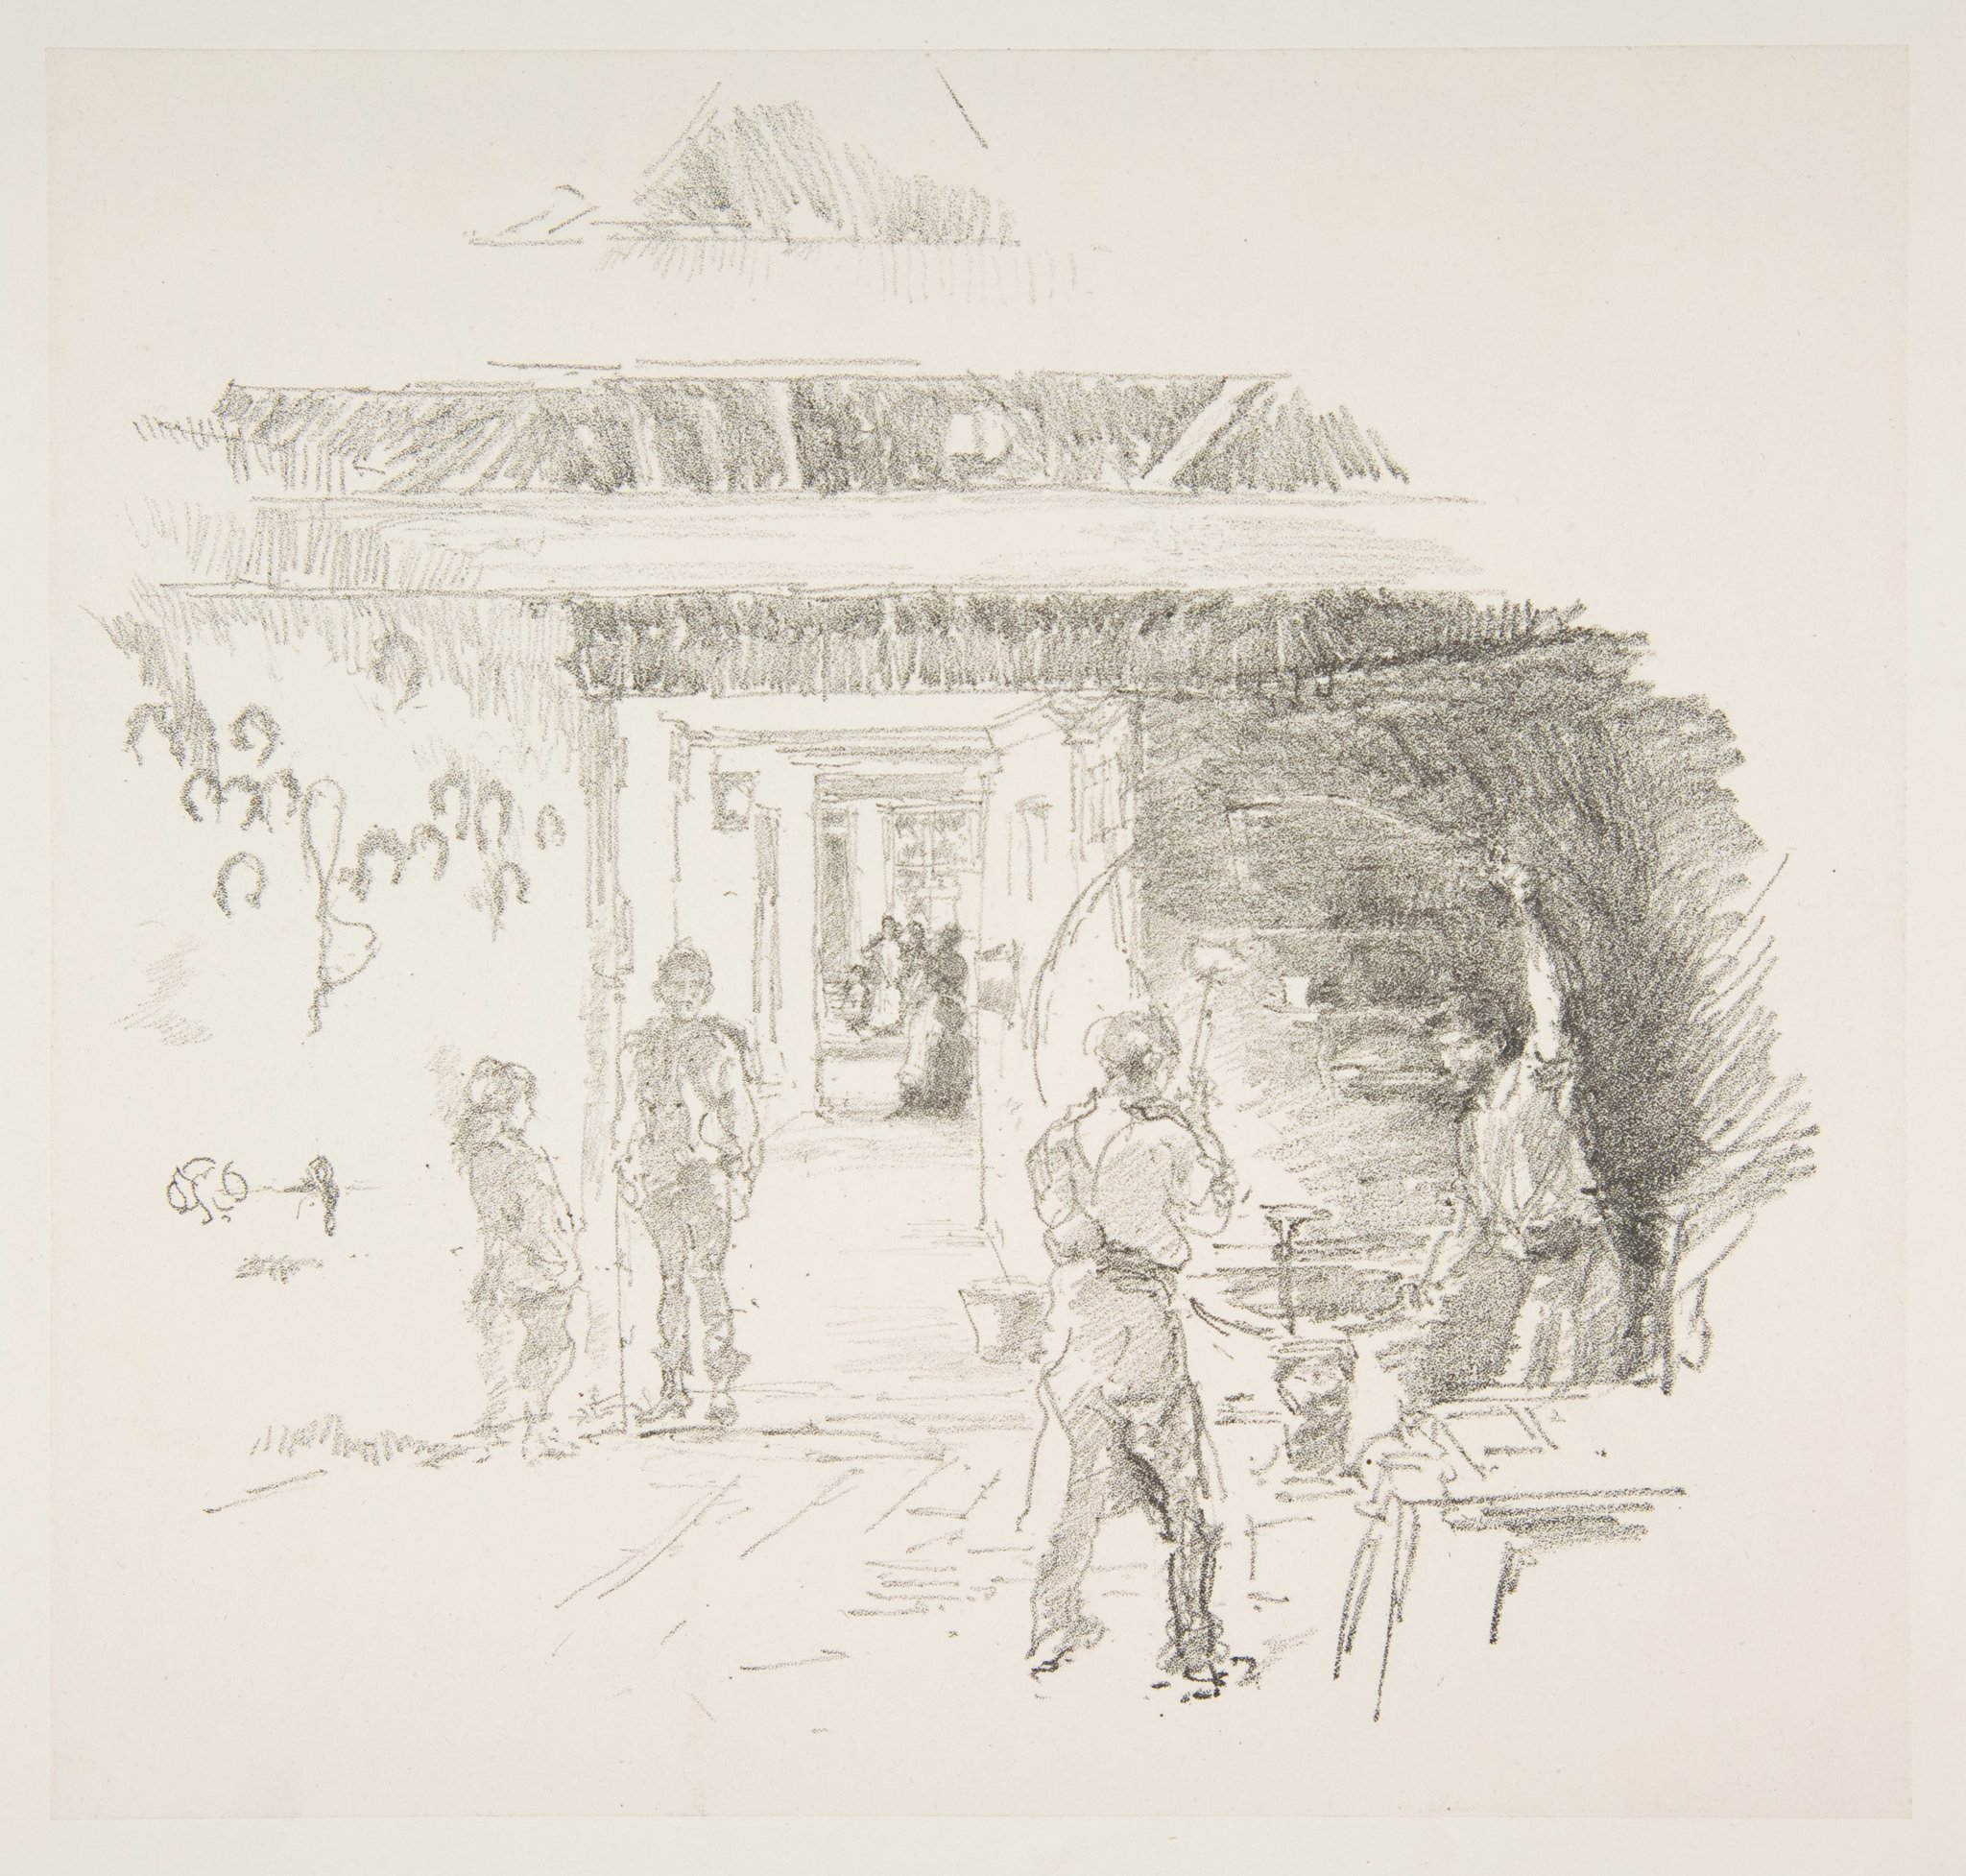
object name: print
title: The Tyresmith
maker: james mcneill whistler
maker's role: artist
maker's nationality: american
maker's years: 1834-1903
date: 1890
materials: chine, paper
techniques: printing, lithography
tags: doorways,men,working